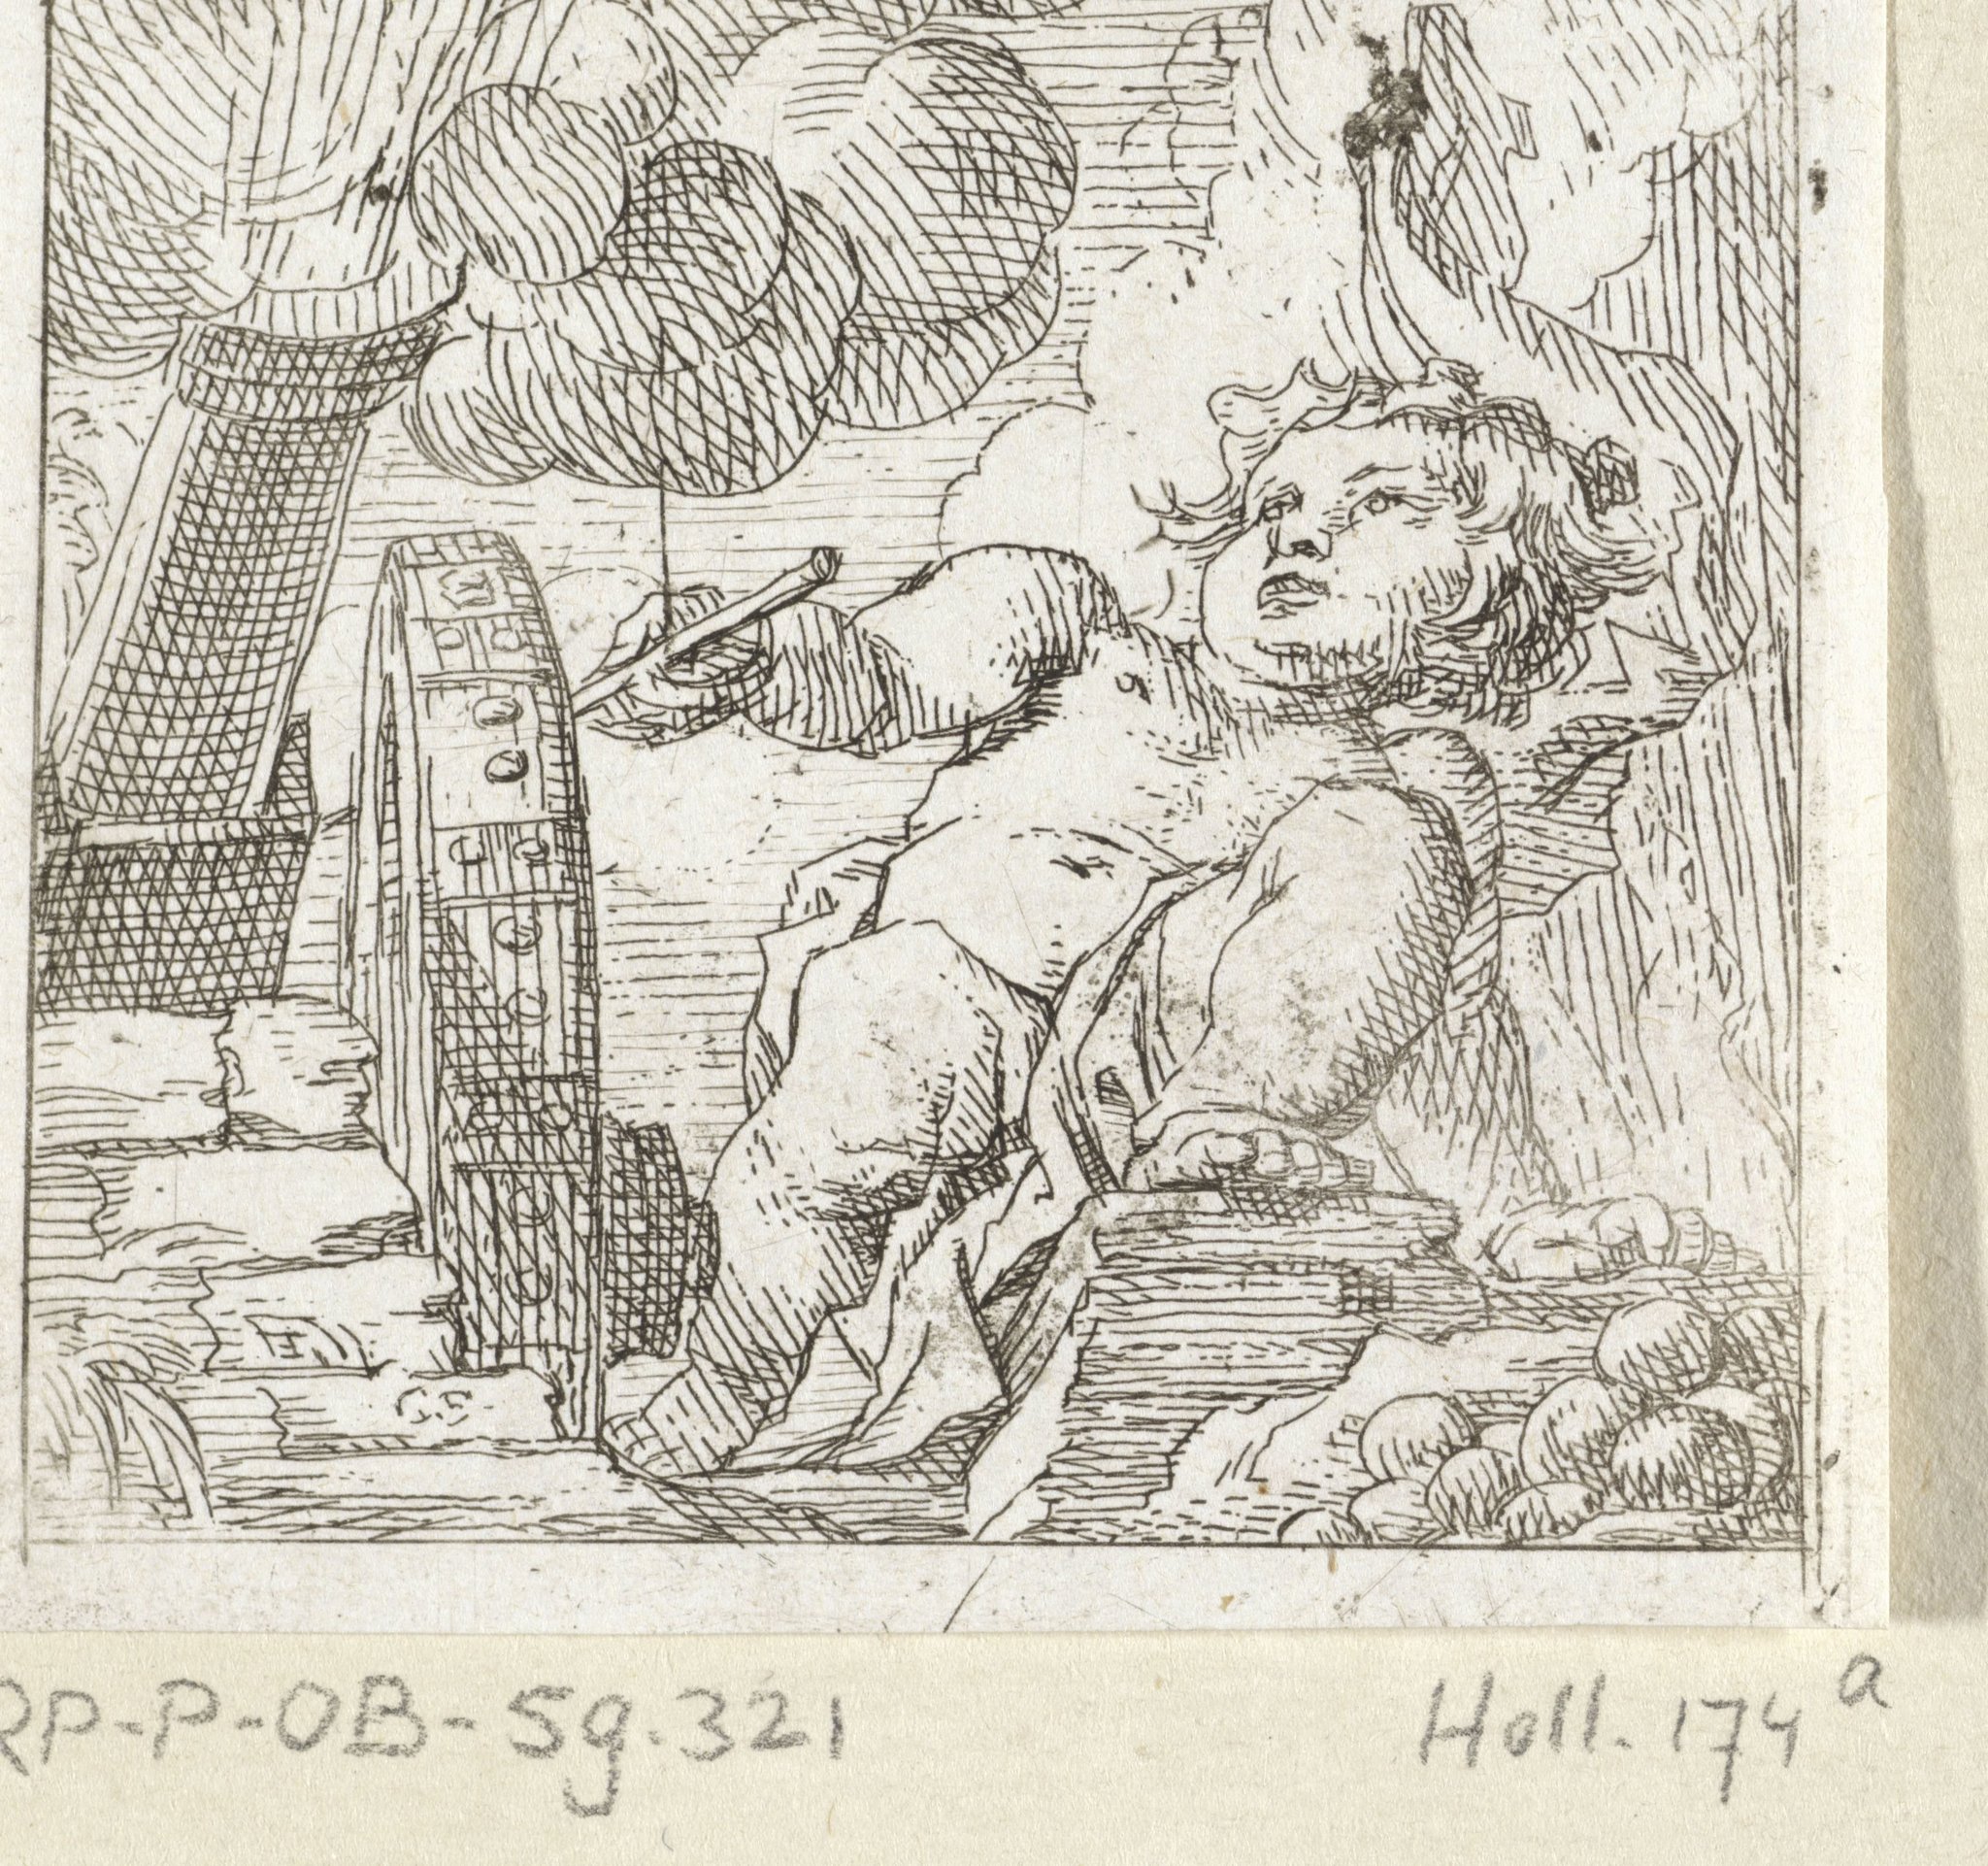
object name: print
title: Kind bij een kanon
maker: cornelis schut (i)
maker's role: draughtsman, print maker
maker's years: 1597-1655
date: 1618-1655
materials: paper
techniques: etching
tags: child, firearms: cannon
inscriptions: collector's mark: Lugt 240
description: Een kind vuurt een kanon af. Het heeft een lont in de hand. Rechts op de voorgrond een stapel kanonskogels.